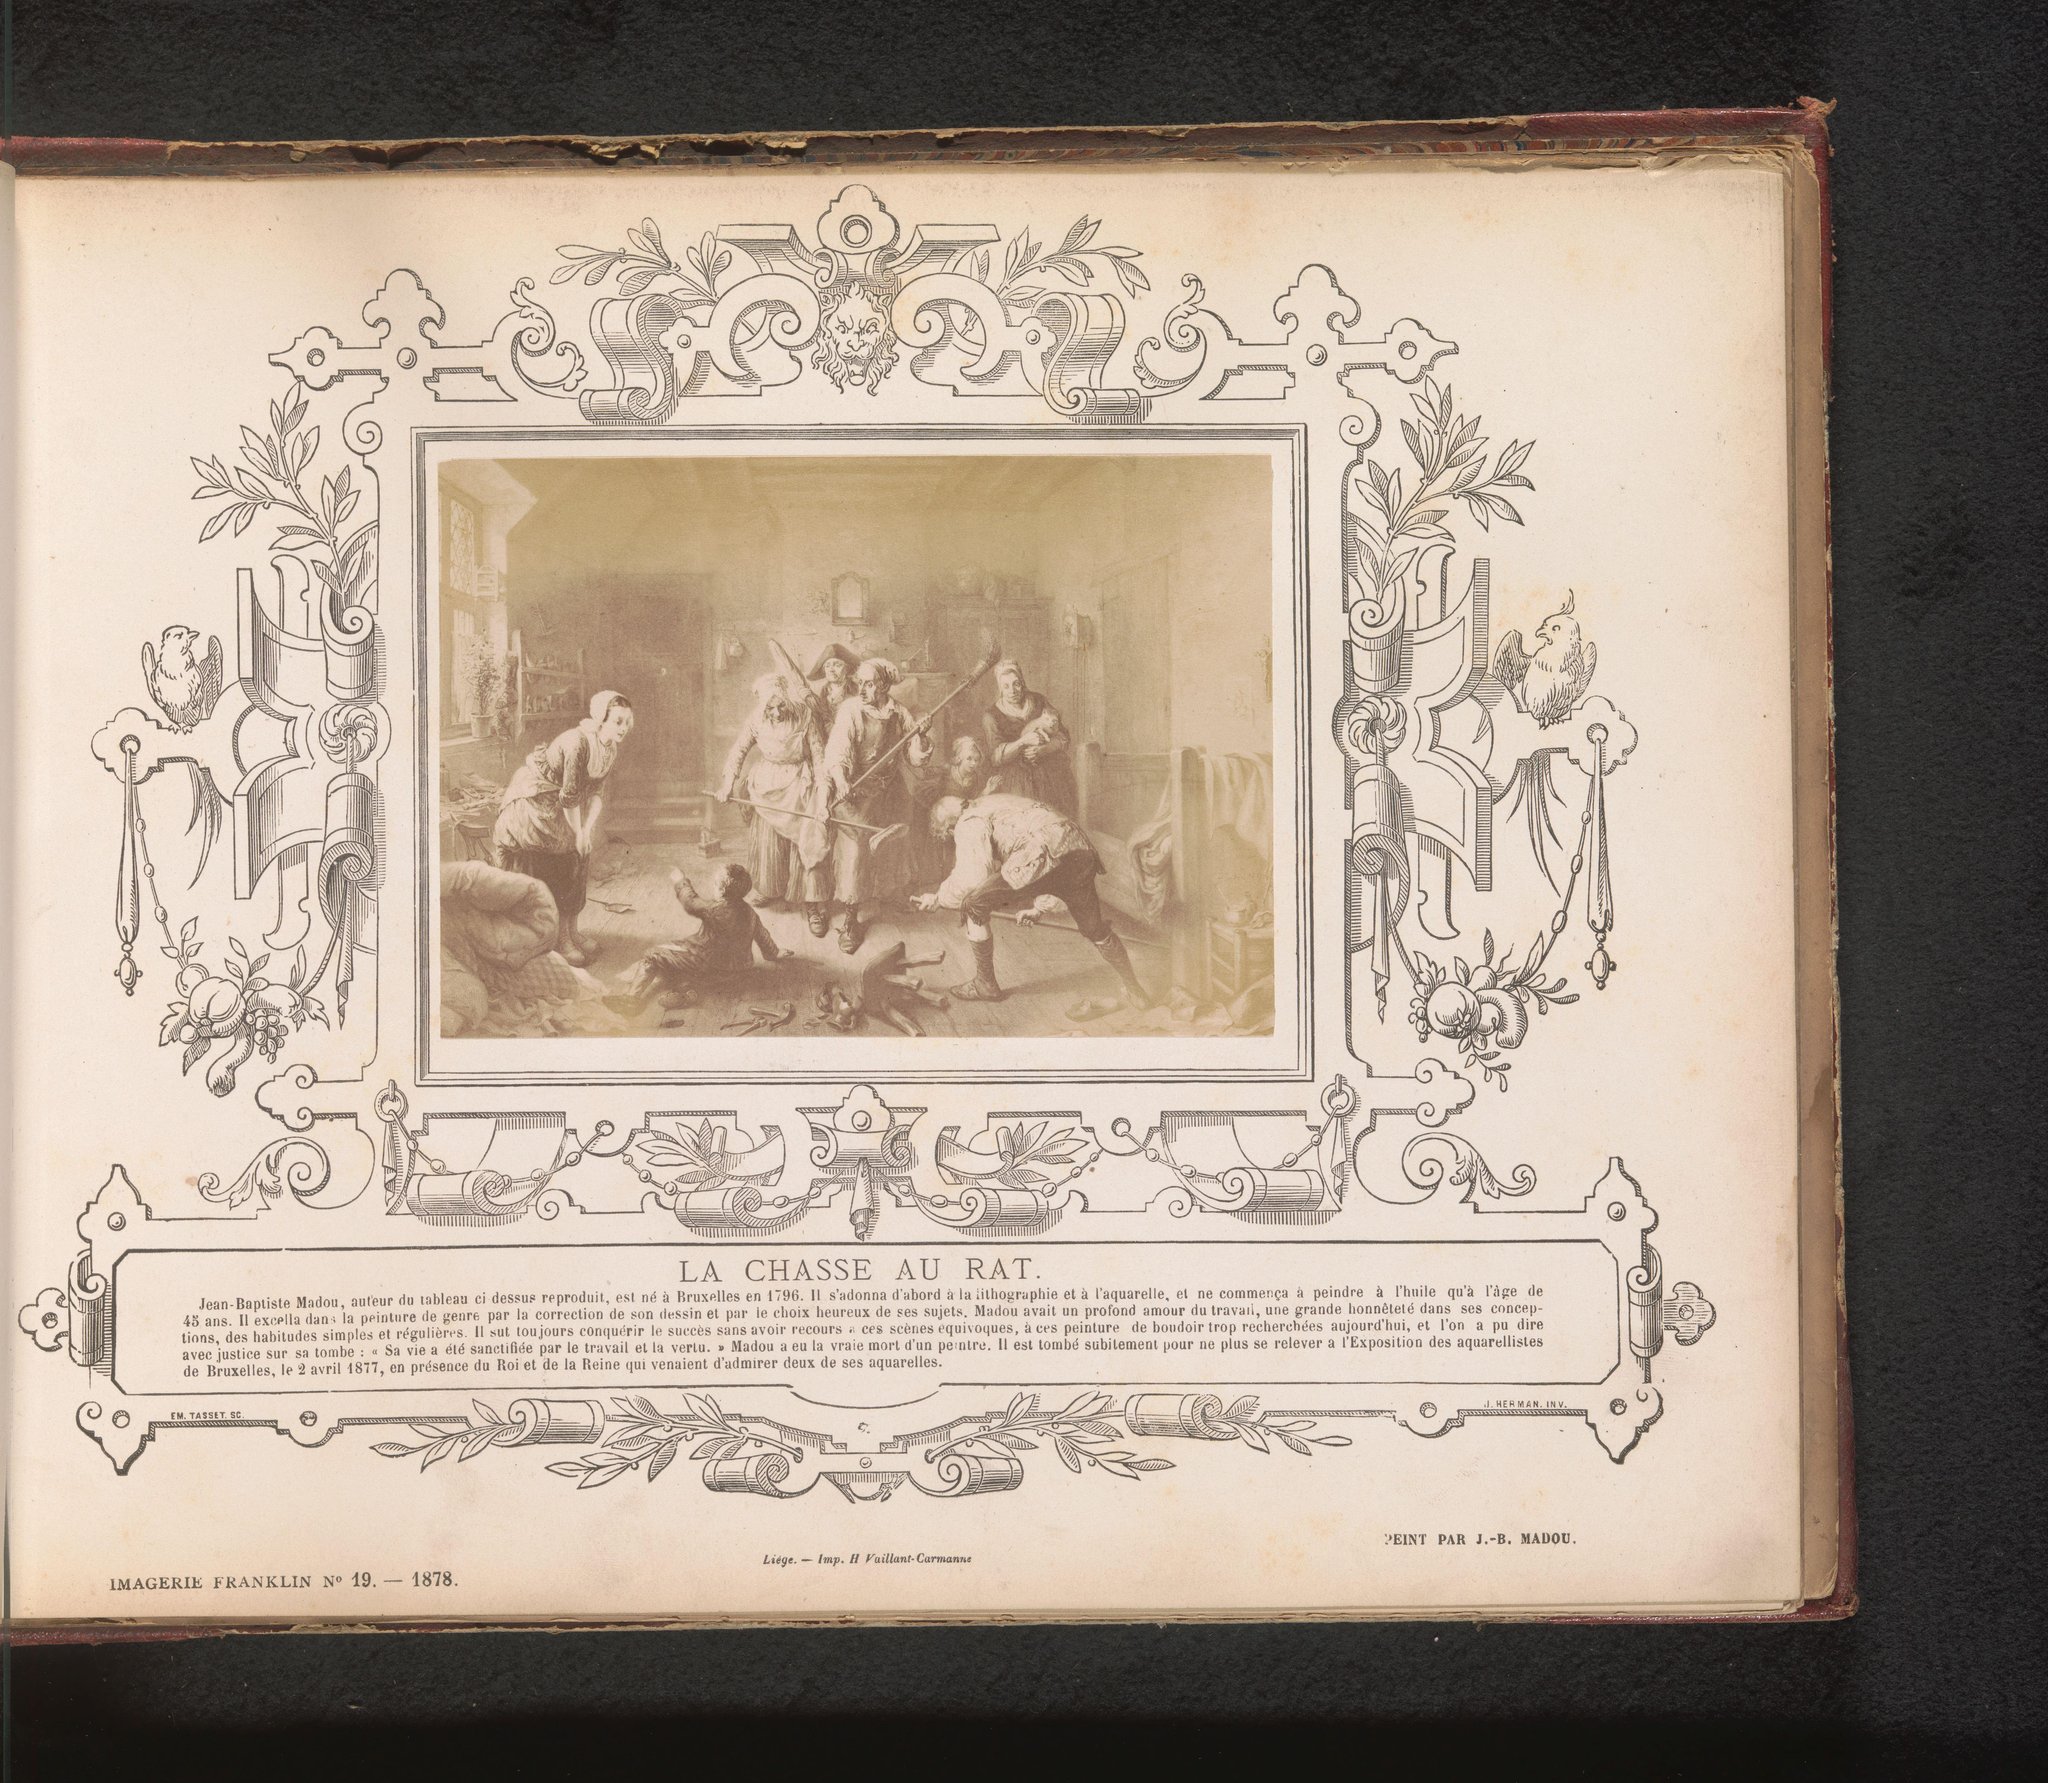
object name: photograph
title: La Chasse au Rat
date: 1873-1878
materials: photographic support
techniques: albumen print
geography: liège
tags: rodents: rat, family life at home, bedroom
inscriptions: name: ‘EM. TASSET, SC.’, name: ‘J. HERMAN, INV.’, inscription: ‘Jean-Baptiste Madou (...) ses aquarelles’, inscription: ‘IMAGERIE FRANKLIN No 19. - 1878.’